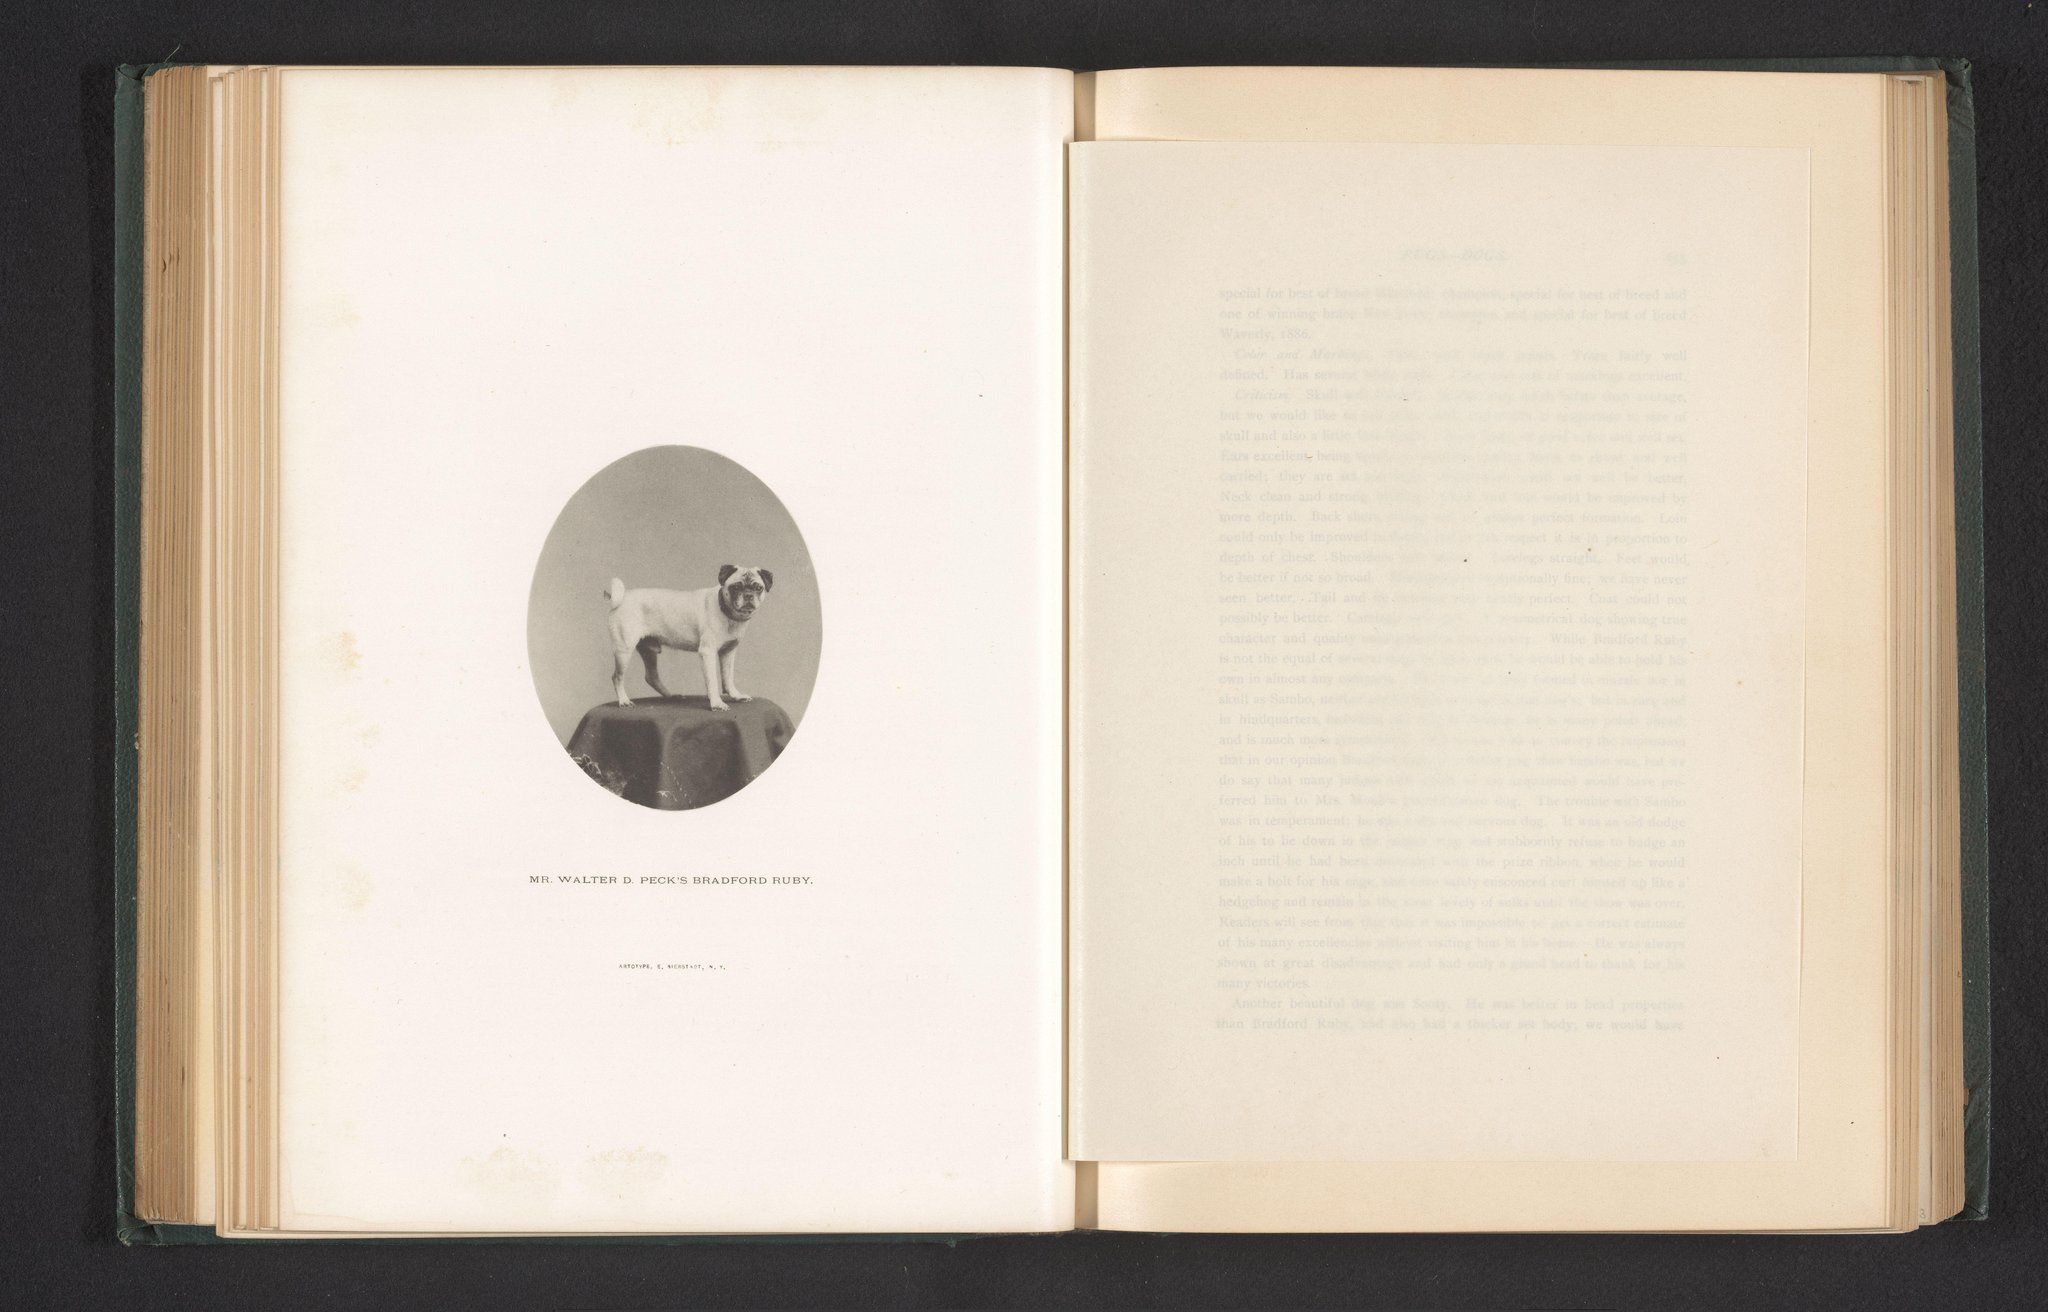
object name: page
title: Mr. Walter D. Peck's Bradford Ruby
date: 1883-1888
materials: paper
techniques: photograph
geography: new york city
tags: dog (pug)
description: Prent tegenover pagina 255, achter semi-transparante omslag.